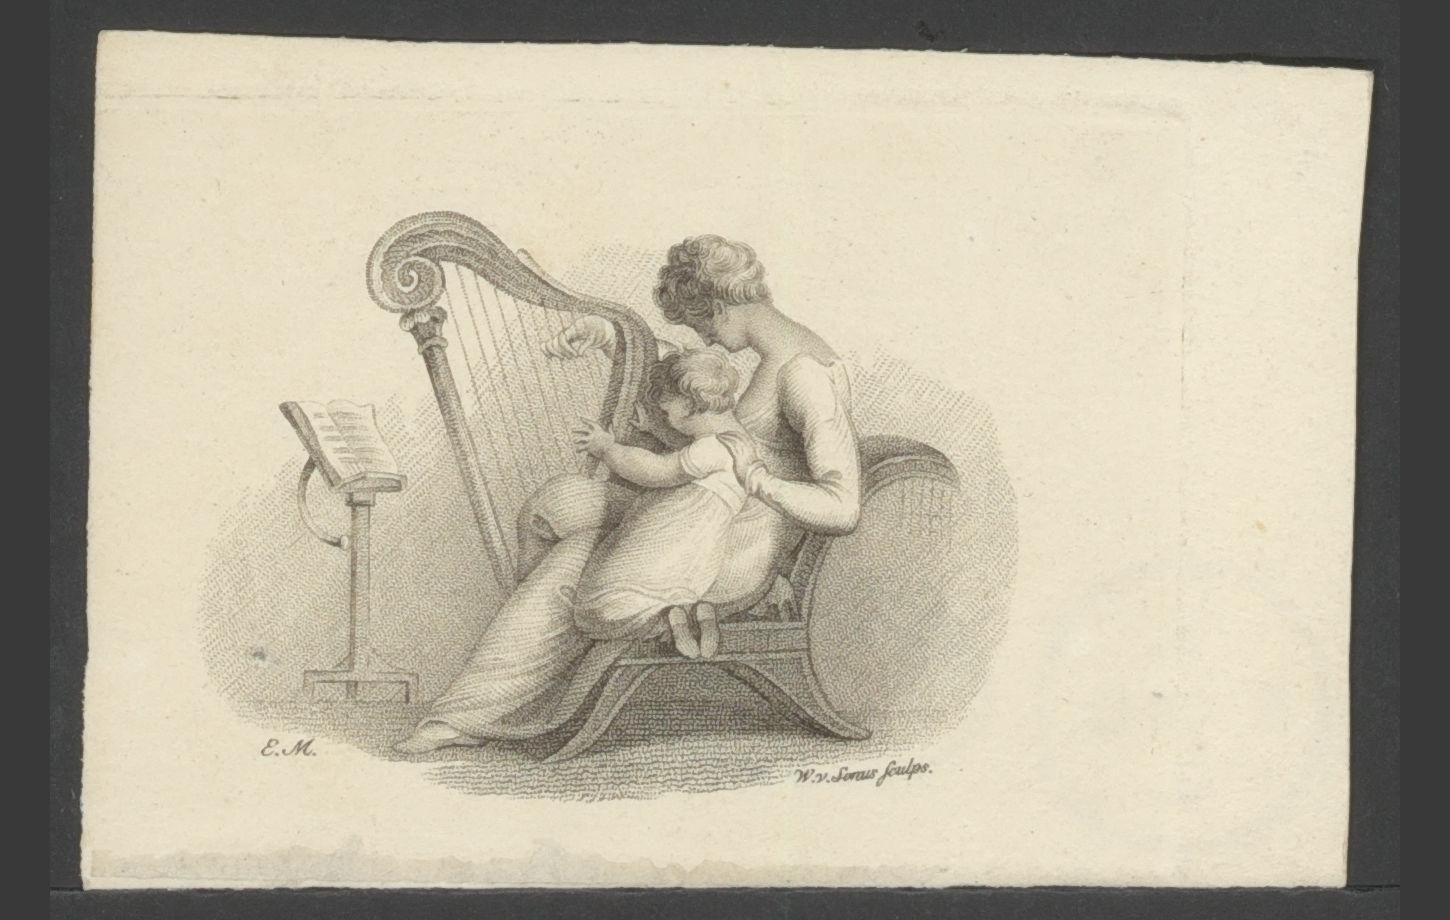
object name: print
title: Moeder en kind bespelen een harp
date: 1787-1834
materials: paper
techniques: engraving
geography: amsterdam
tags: child, harp, mother and baby or young child, lying figure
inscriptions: stamp, collector's mark: Lugt 1641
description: Onderwerpsrubrieken binnen de Atlas Zeden en Gewoonten: Schoone kunsten, Varia.